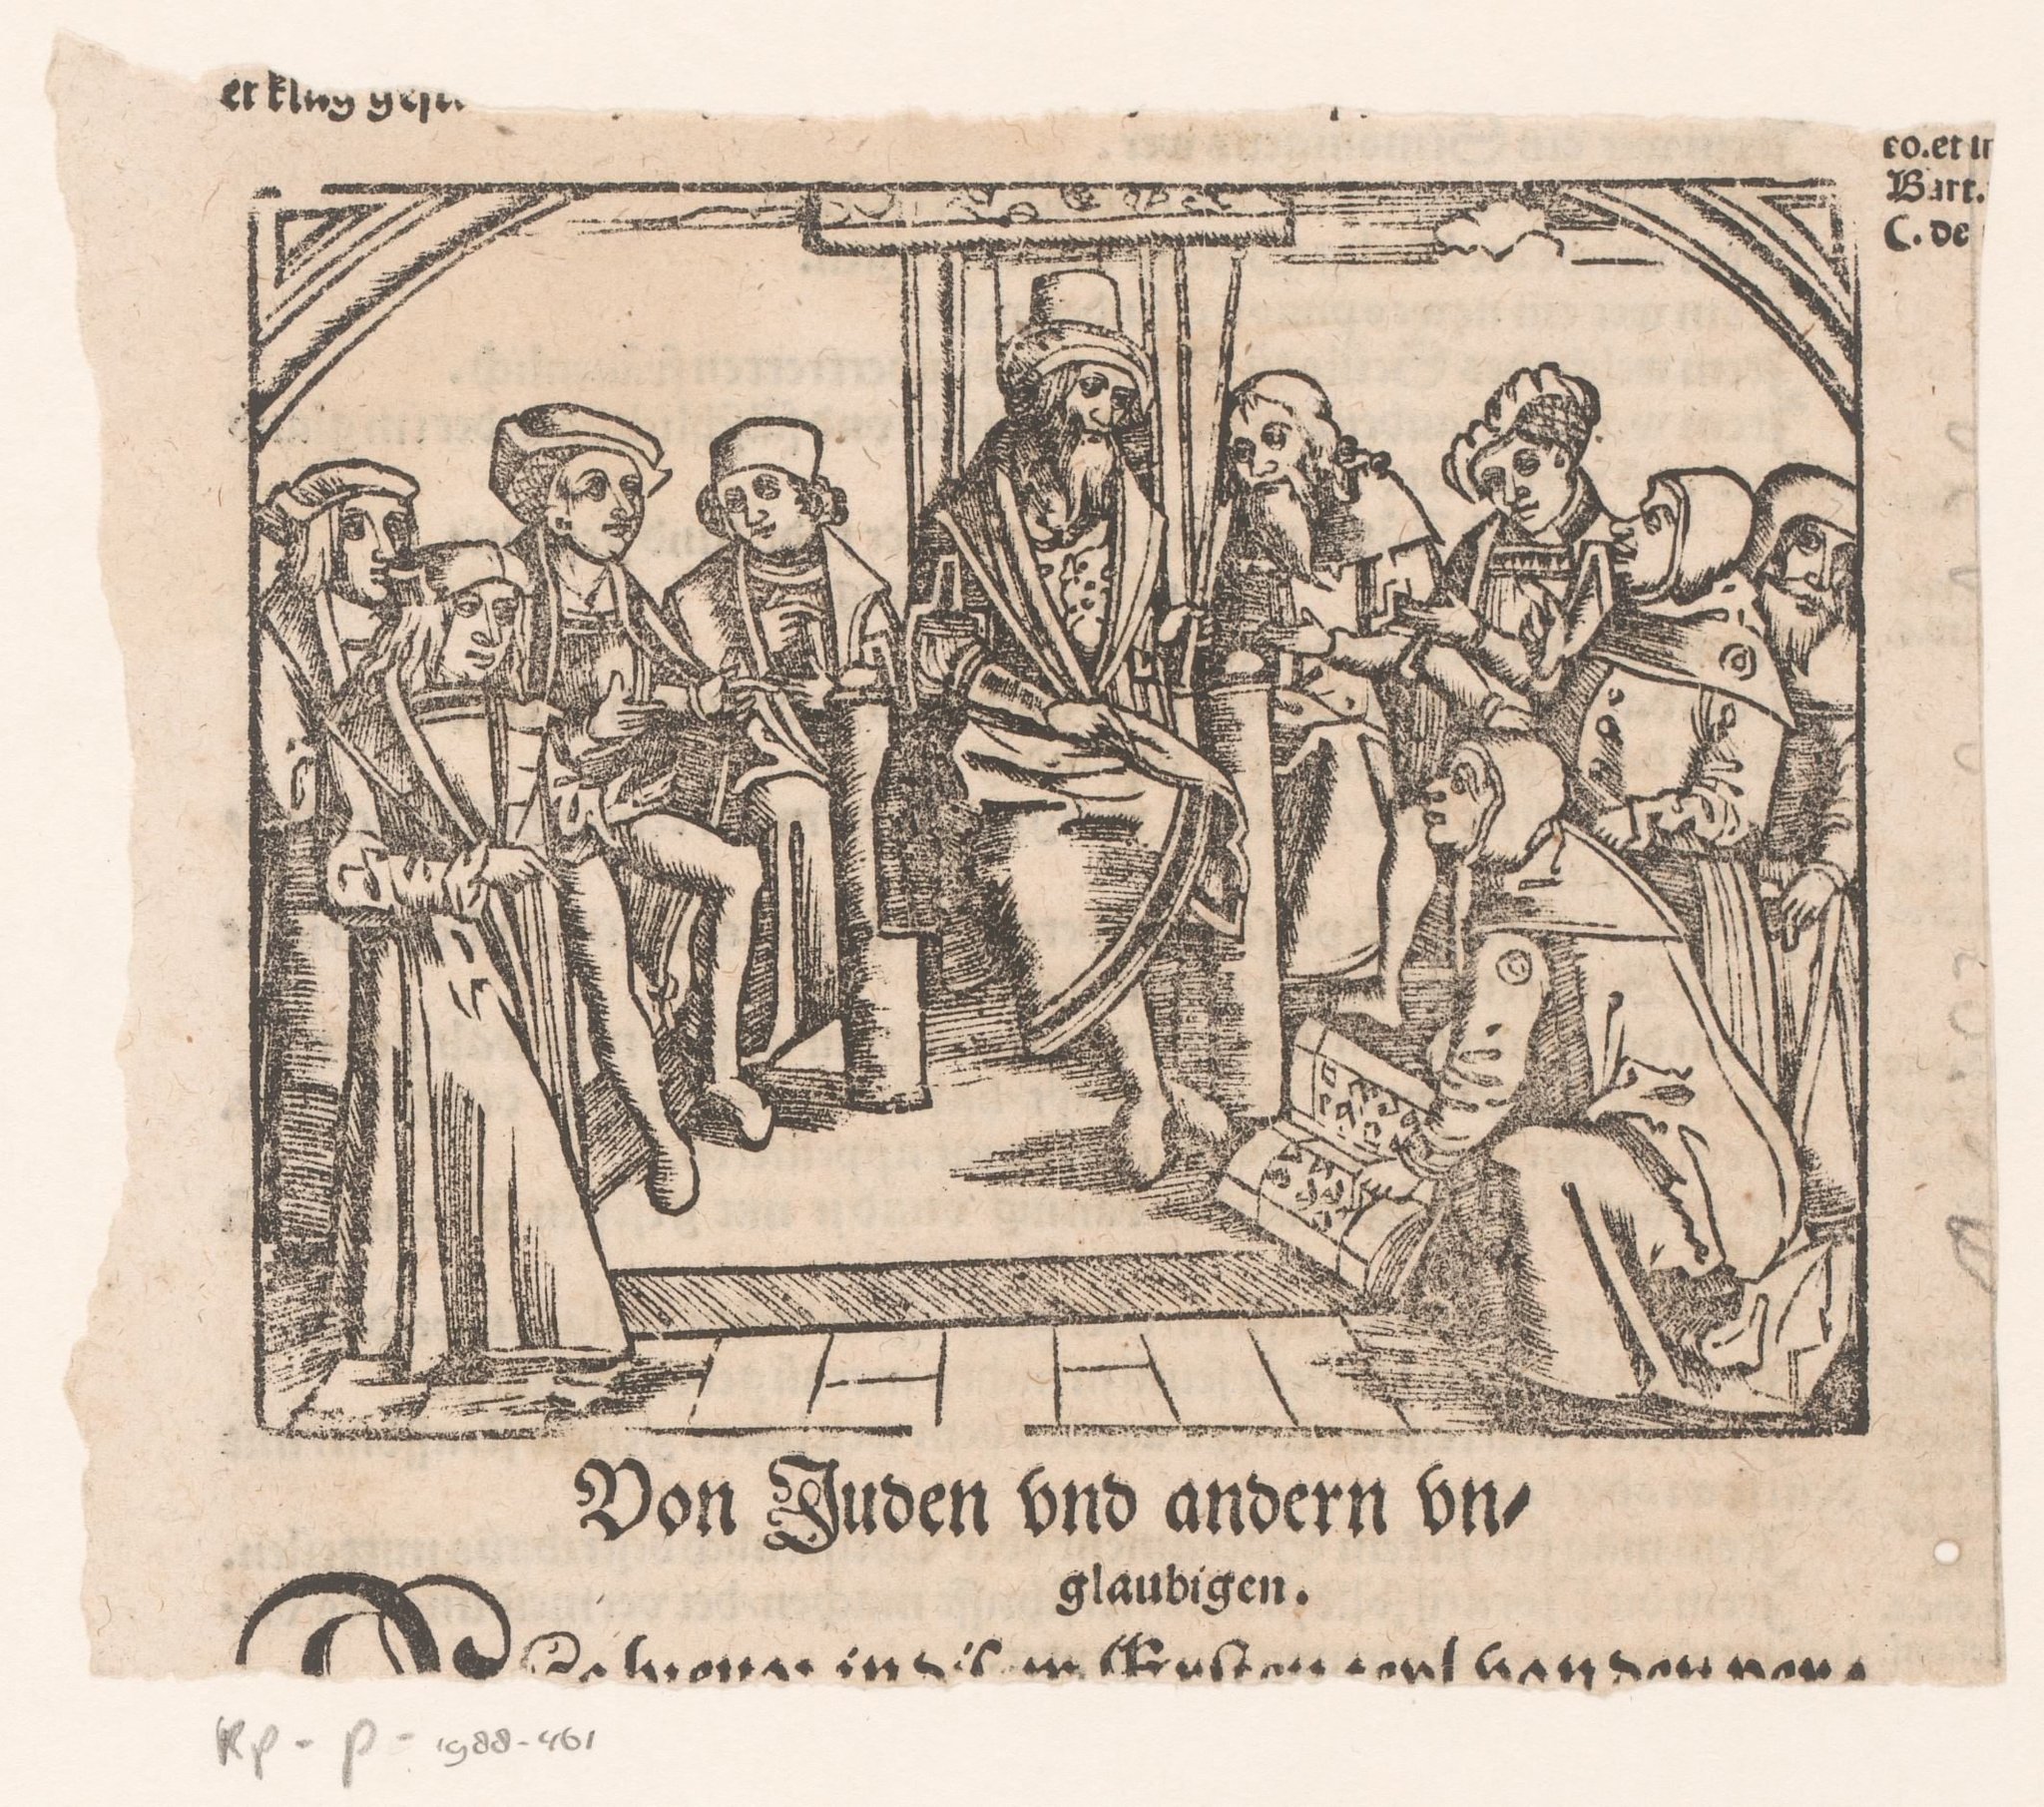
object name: book illustration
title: Von Juden und andern un-glaubigen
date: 1518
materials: paper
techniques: woodcut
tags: persecution of heretics, civil law, the jews, jewish life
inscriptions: collector's mark: Lugt 2228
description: Prent voor het eerst gebruikt in: Tengler, Ulrich. Neü Layenspiegel. Straatsburg: Matthias Hupfuff, 1518.